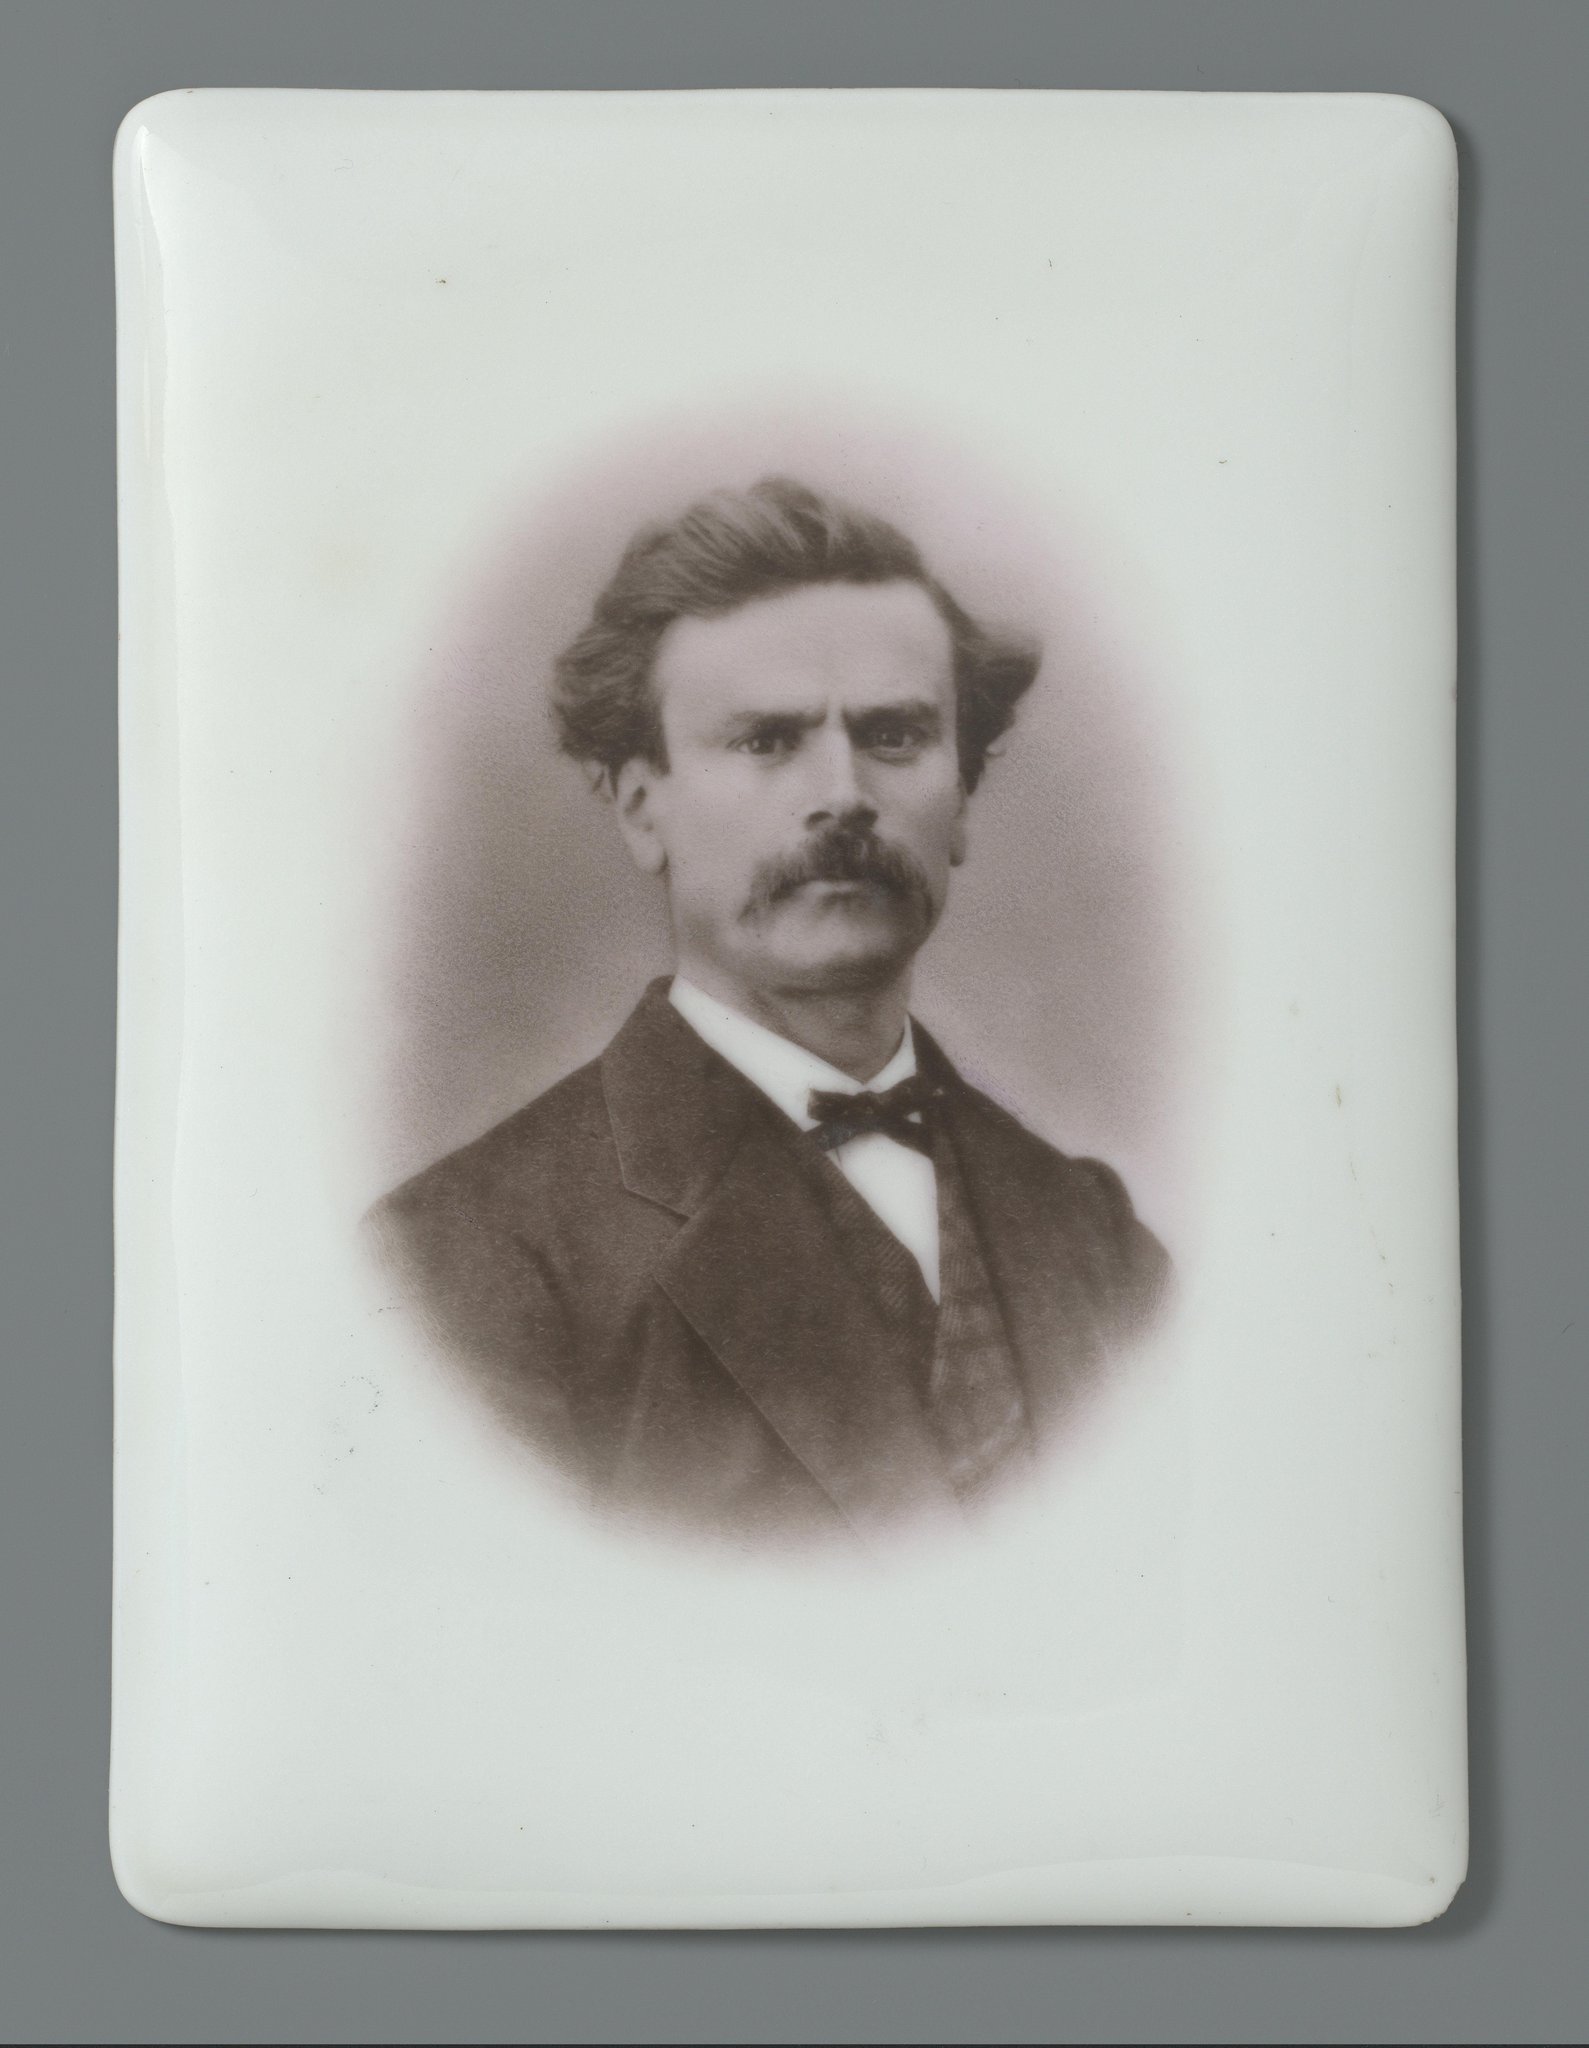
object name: photograph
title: Portret van een onbekende man op porseleinen rechthoekige plaquette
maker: Anonymous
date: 1890-1910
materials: porcelain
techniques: gelatin silver print, unfired photoceramics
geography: france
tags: adult man, anonymous historical person portrayed, france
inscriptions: inscription: ‘106/ C’